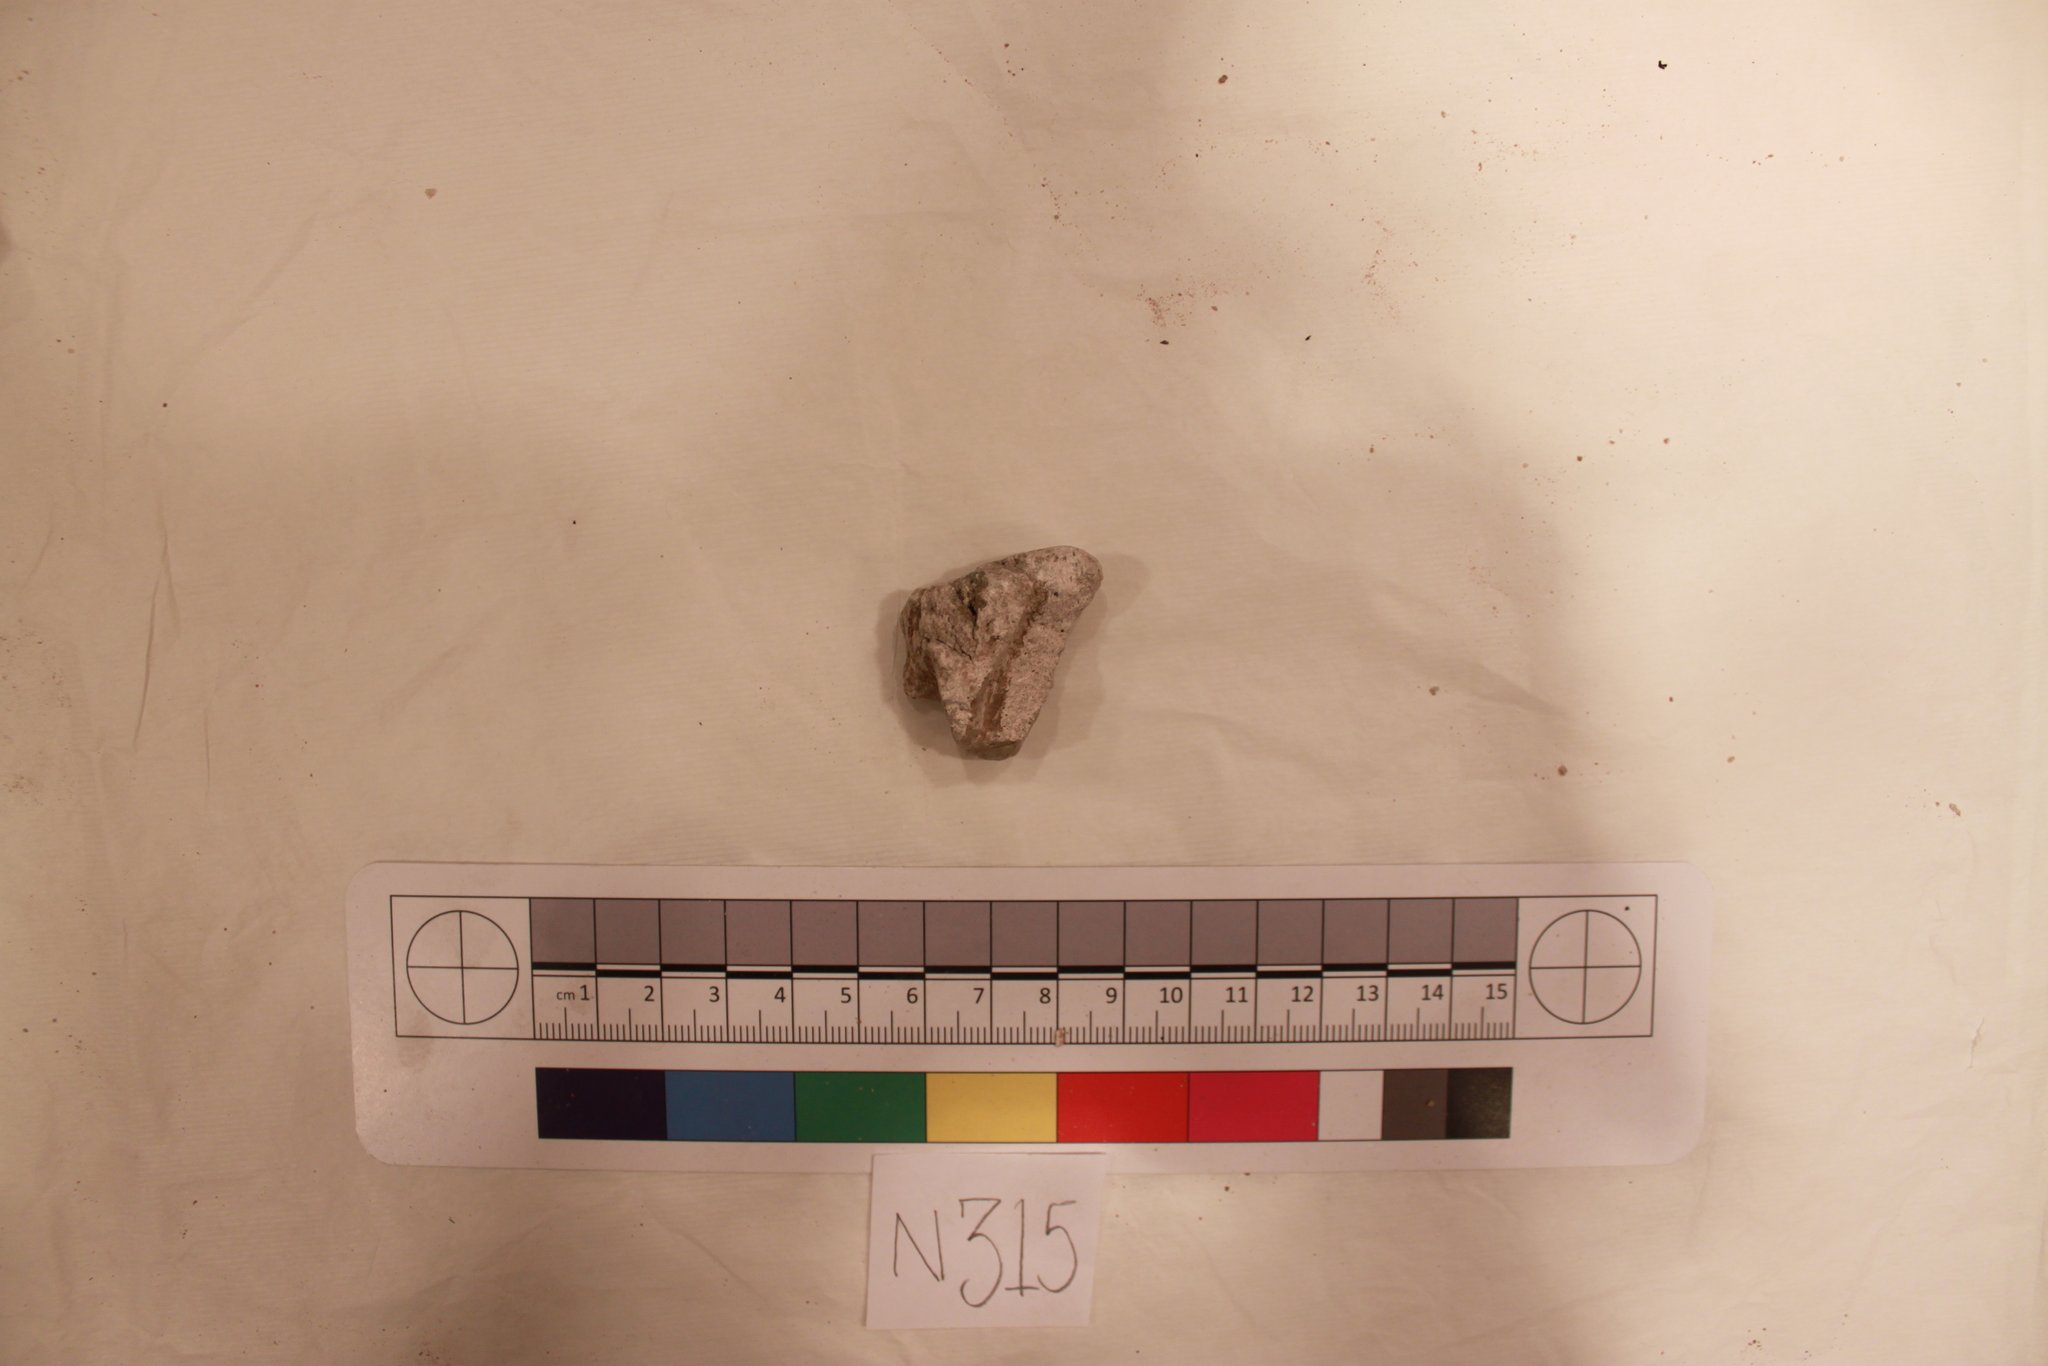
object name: fragment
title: Stucco Fragment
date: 701-1200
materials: plaster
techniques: carving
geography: iran